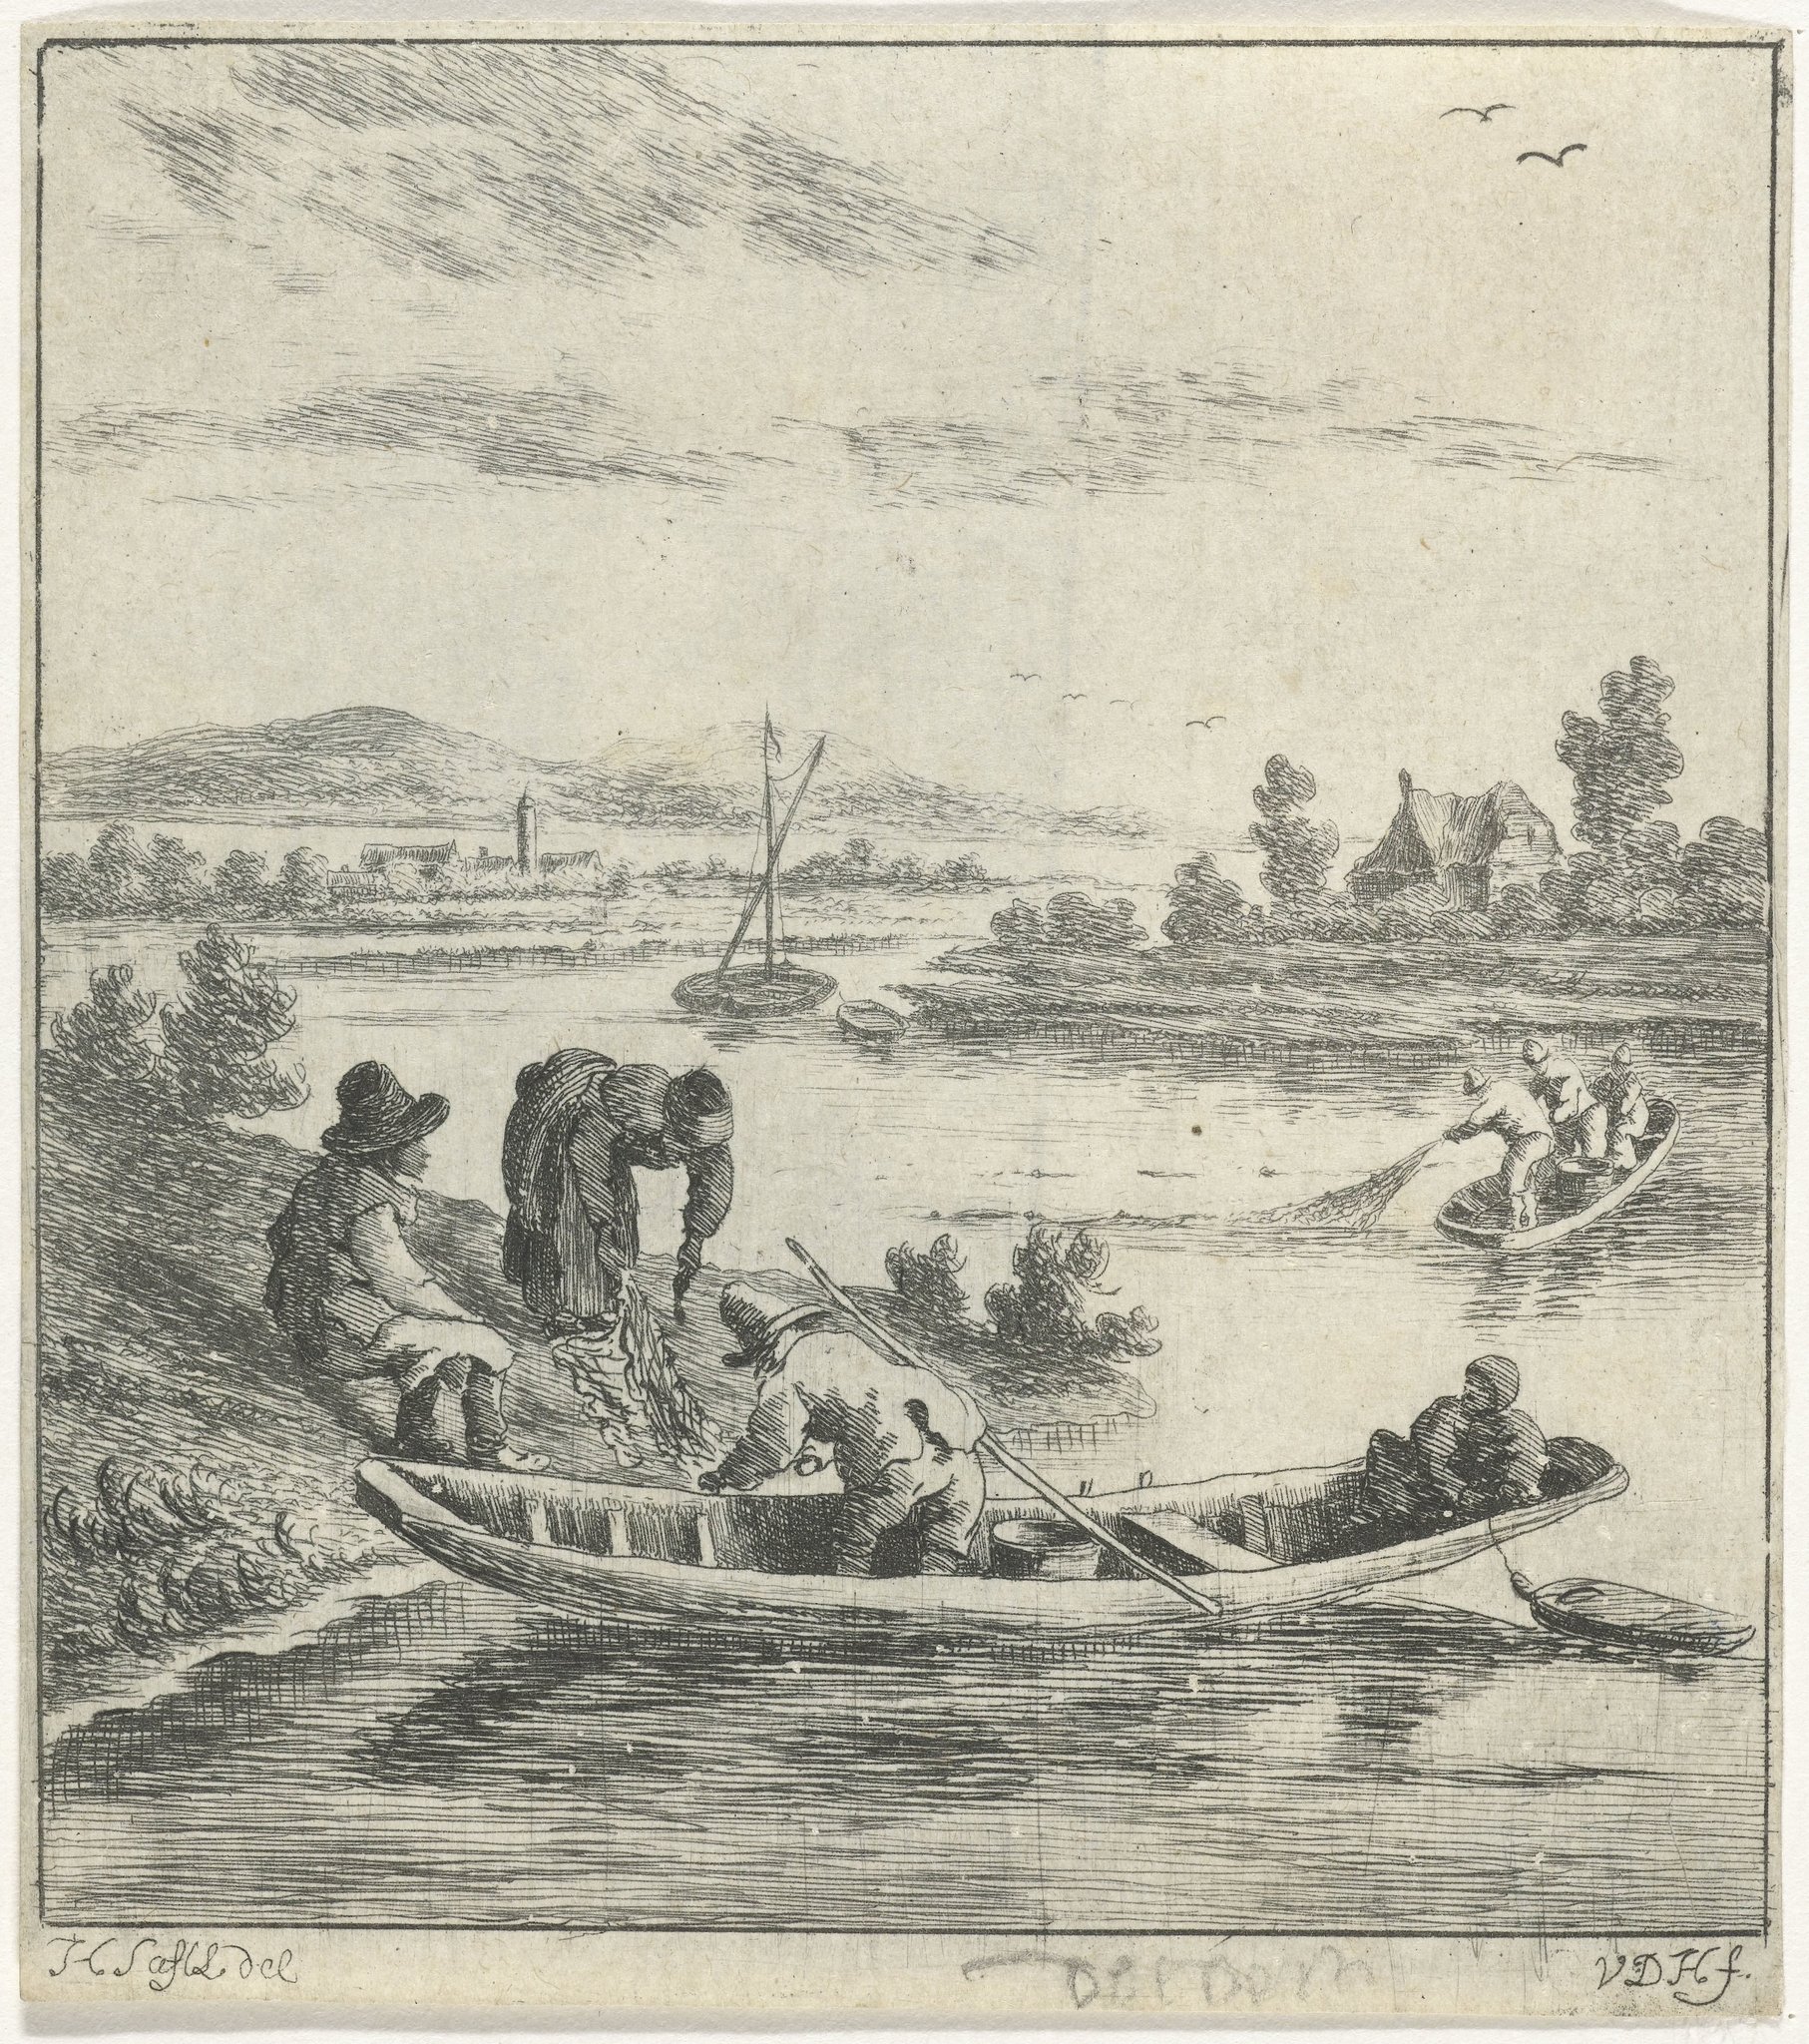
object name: print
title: Vissers op een rivier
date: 1745-1785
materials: paper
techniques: etching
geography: northern netherlands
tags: fresh-water fishery, rowing-boat, canoe, etc., landscapes with waters, waterscapes, seascapes (in the temperate zone) (+ landscape with figures, staffage)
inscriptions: plate: ‘een deel van een boog en een boom , op de voorgrond een wolk’, collector's mark: Lugt 2228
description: Vissers bezig met hun netten aan de oever van een rivier, op de achtergrond drie vissers in een bootje op het water.